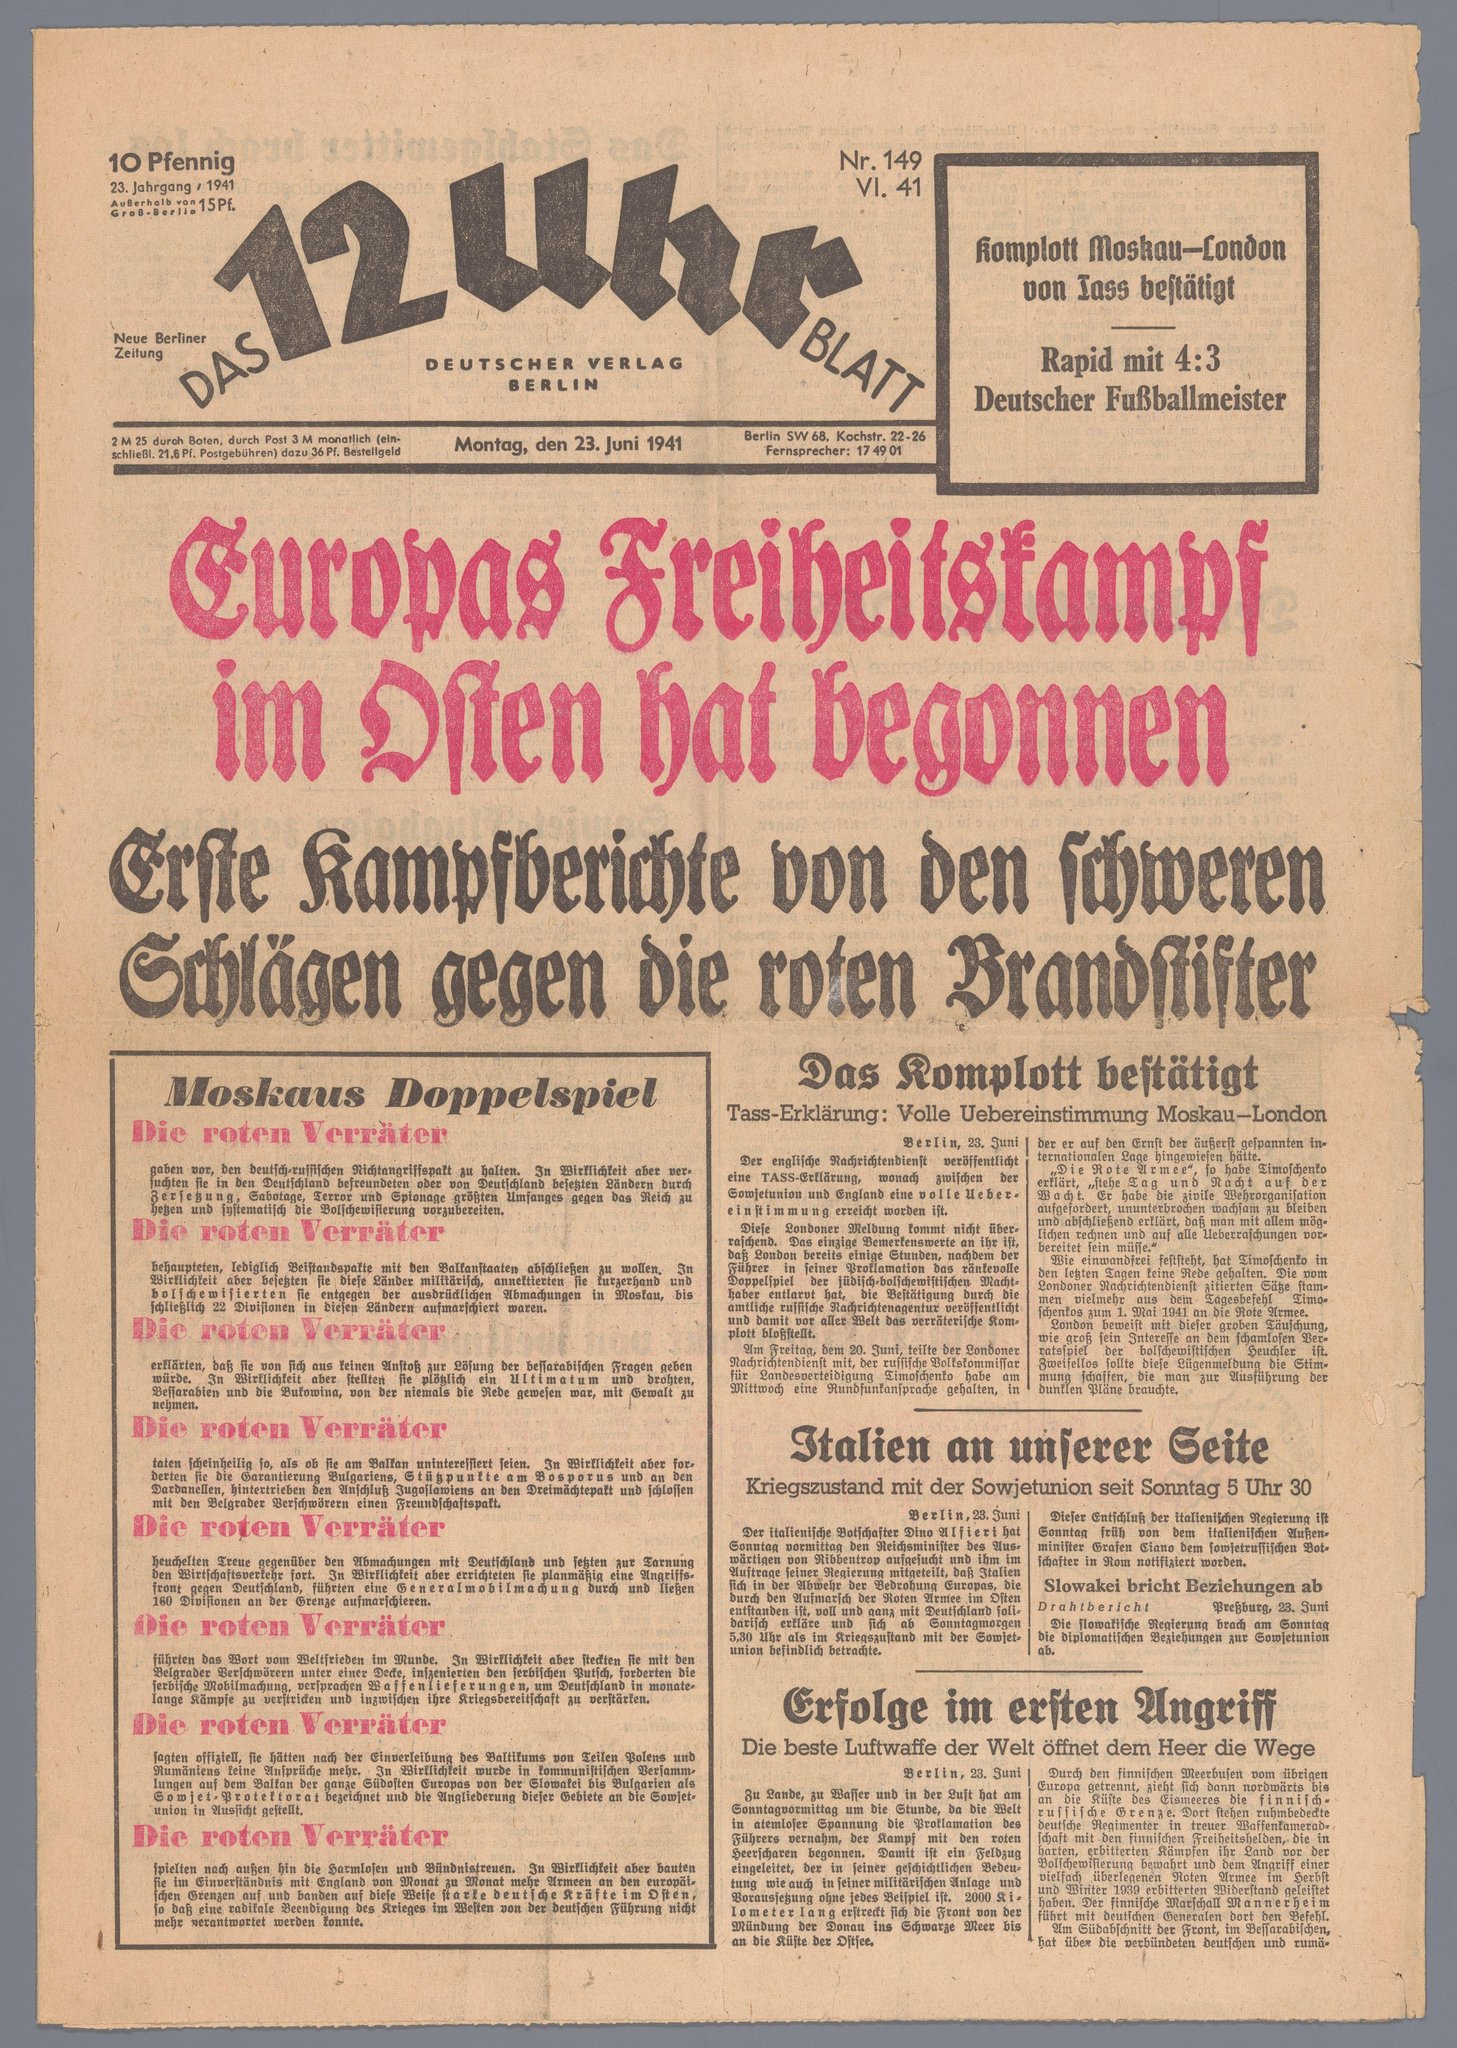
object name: newspaper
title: Das 12 Uhrblatt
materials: paper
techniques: printing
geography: berlin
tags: tweede wereldoorlog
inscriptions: date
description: Aflevering nr. 149 van Duitse krant, 6 pp. Gedateerd; Montag, den 23 Juni 1941. Opschrift: 'Europas Freiheitskampf / im Osten hat begonnen'.